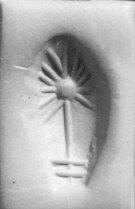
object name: stamp seal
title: Stamp seal (duck-shaped) with divine symbol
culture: assyro-babylonian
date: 700-501 BCE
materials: stone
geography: mesopotamia